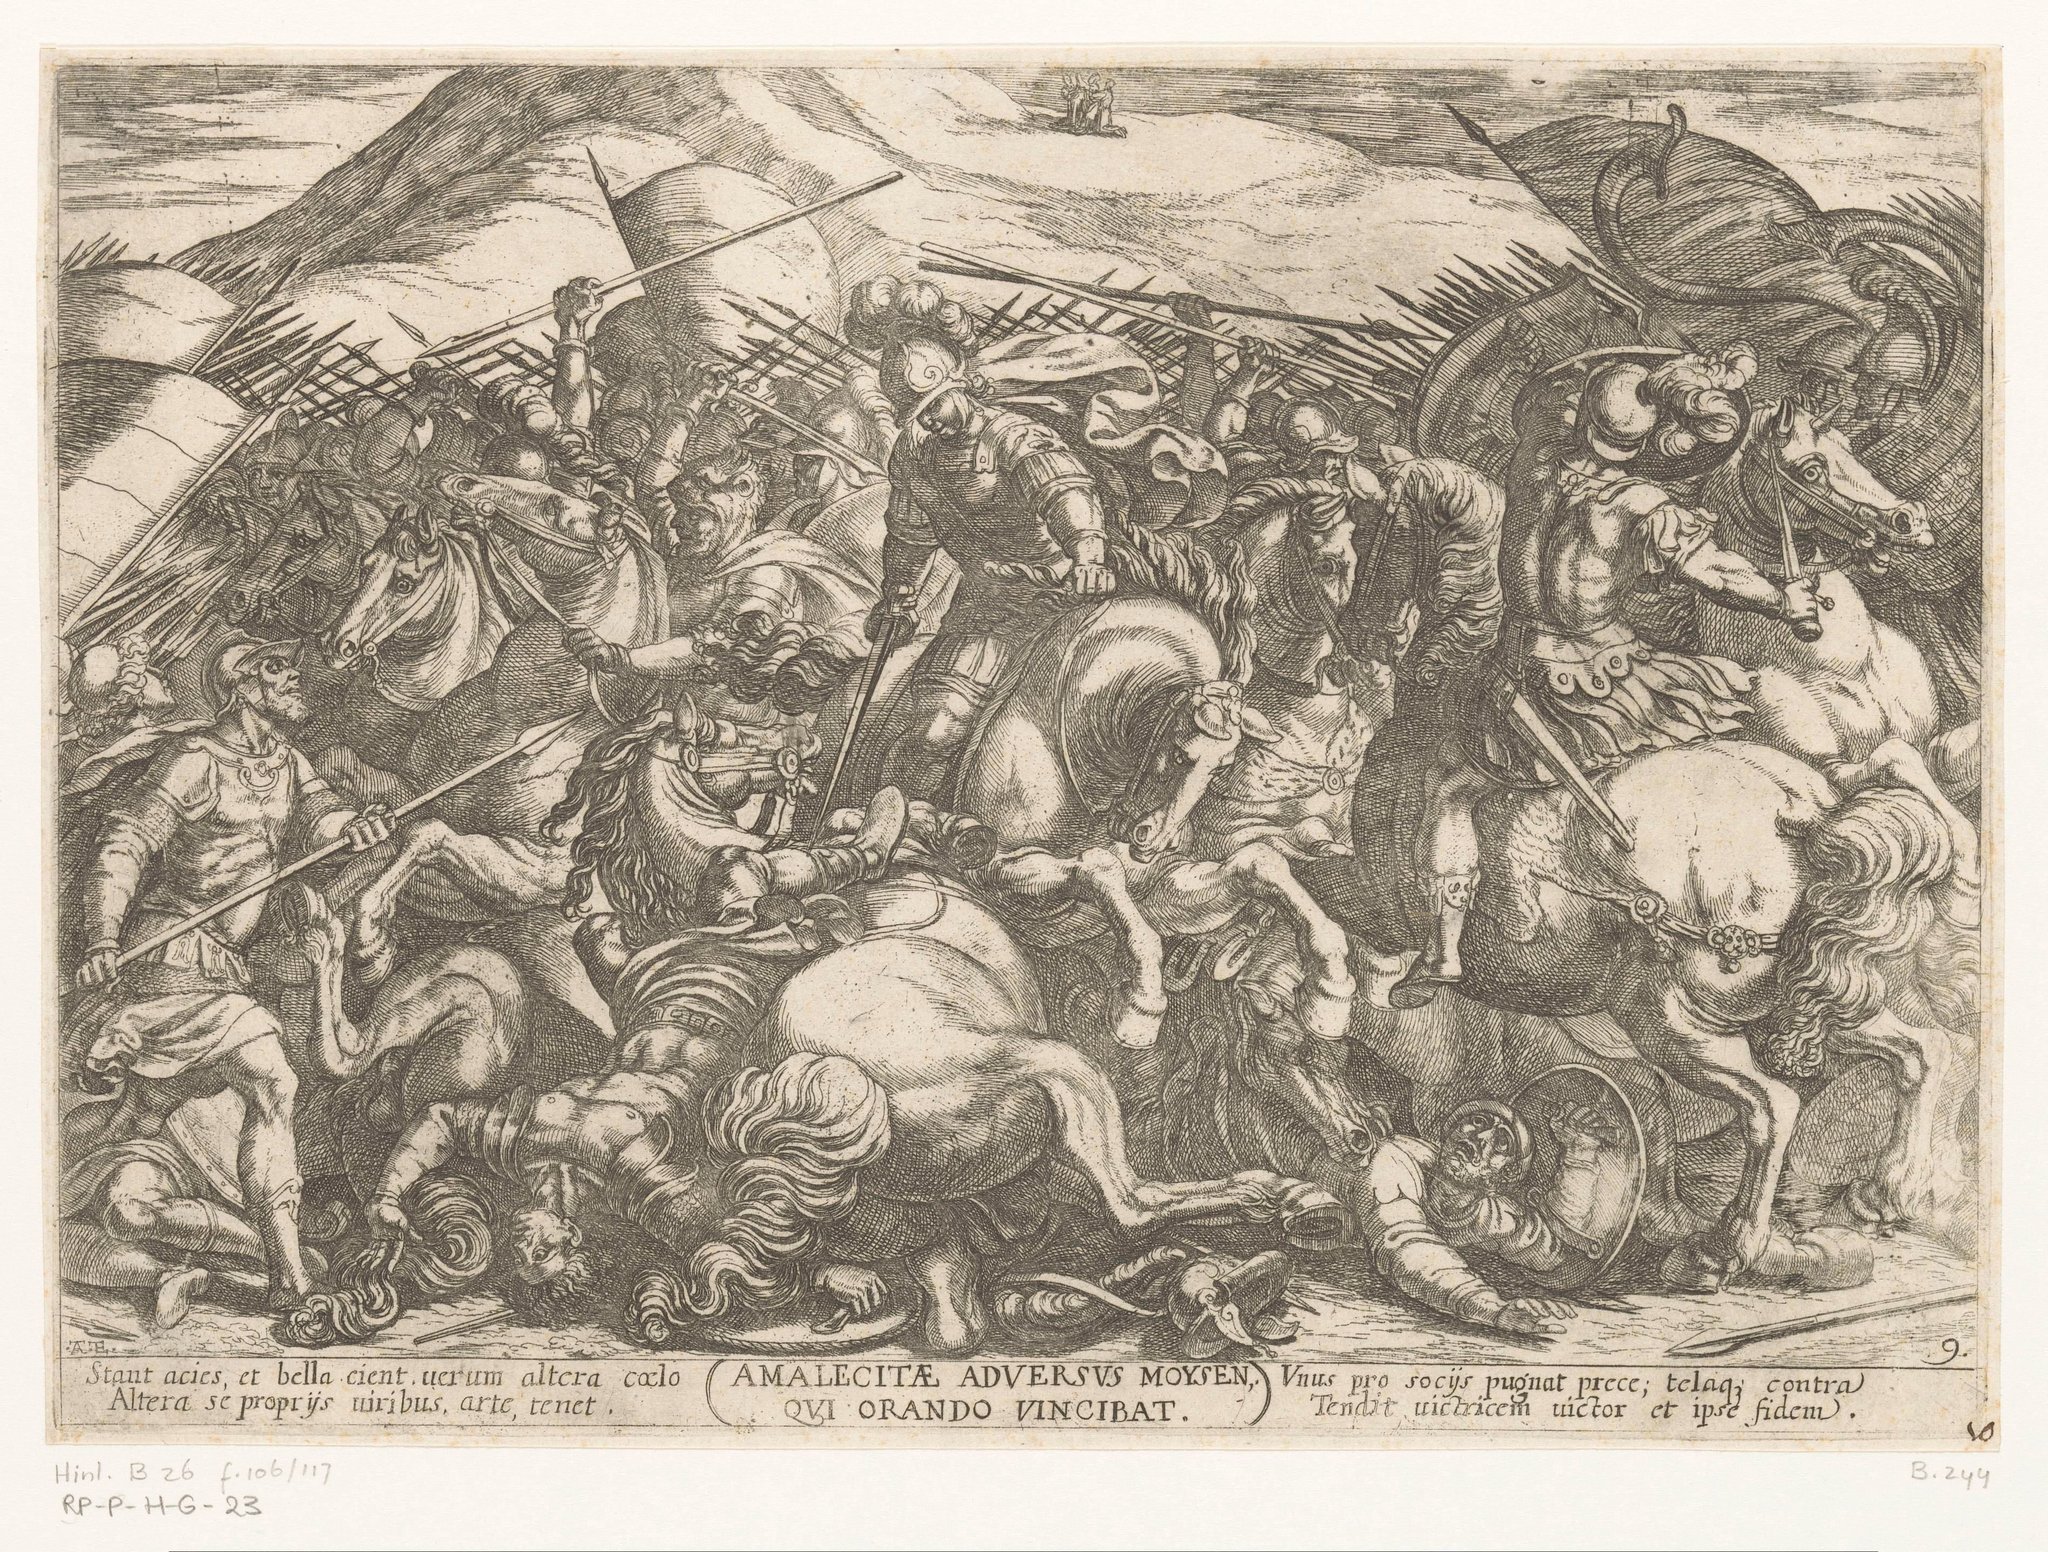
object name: print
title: Oudtestamentische strijdscènes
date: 1613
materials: paper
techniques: etching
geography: italy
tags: the amalekites come to war against the israelites (exodus 17:8-16)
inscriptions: number: ‘10’, collector's mark: ‘Hinloopen’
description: Een strijdgewoel van soldaten met speren te paard en te voet. De Israëlieten strijden met de Amalekieten. Titel en onderschrift in het Latijn in de ondermarge.